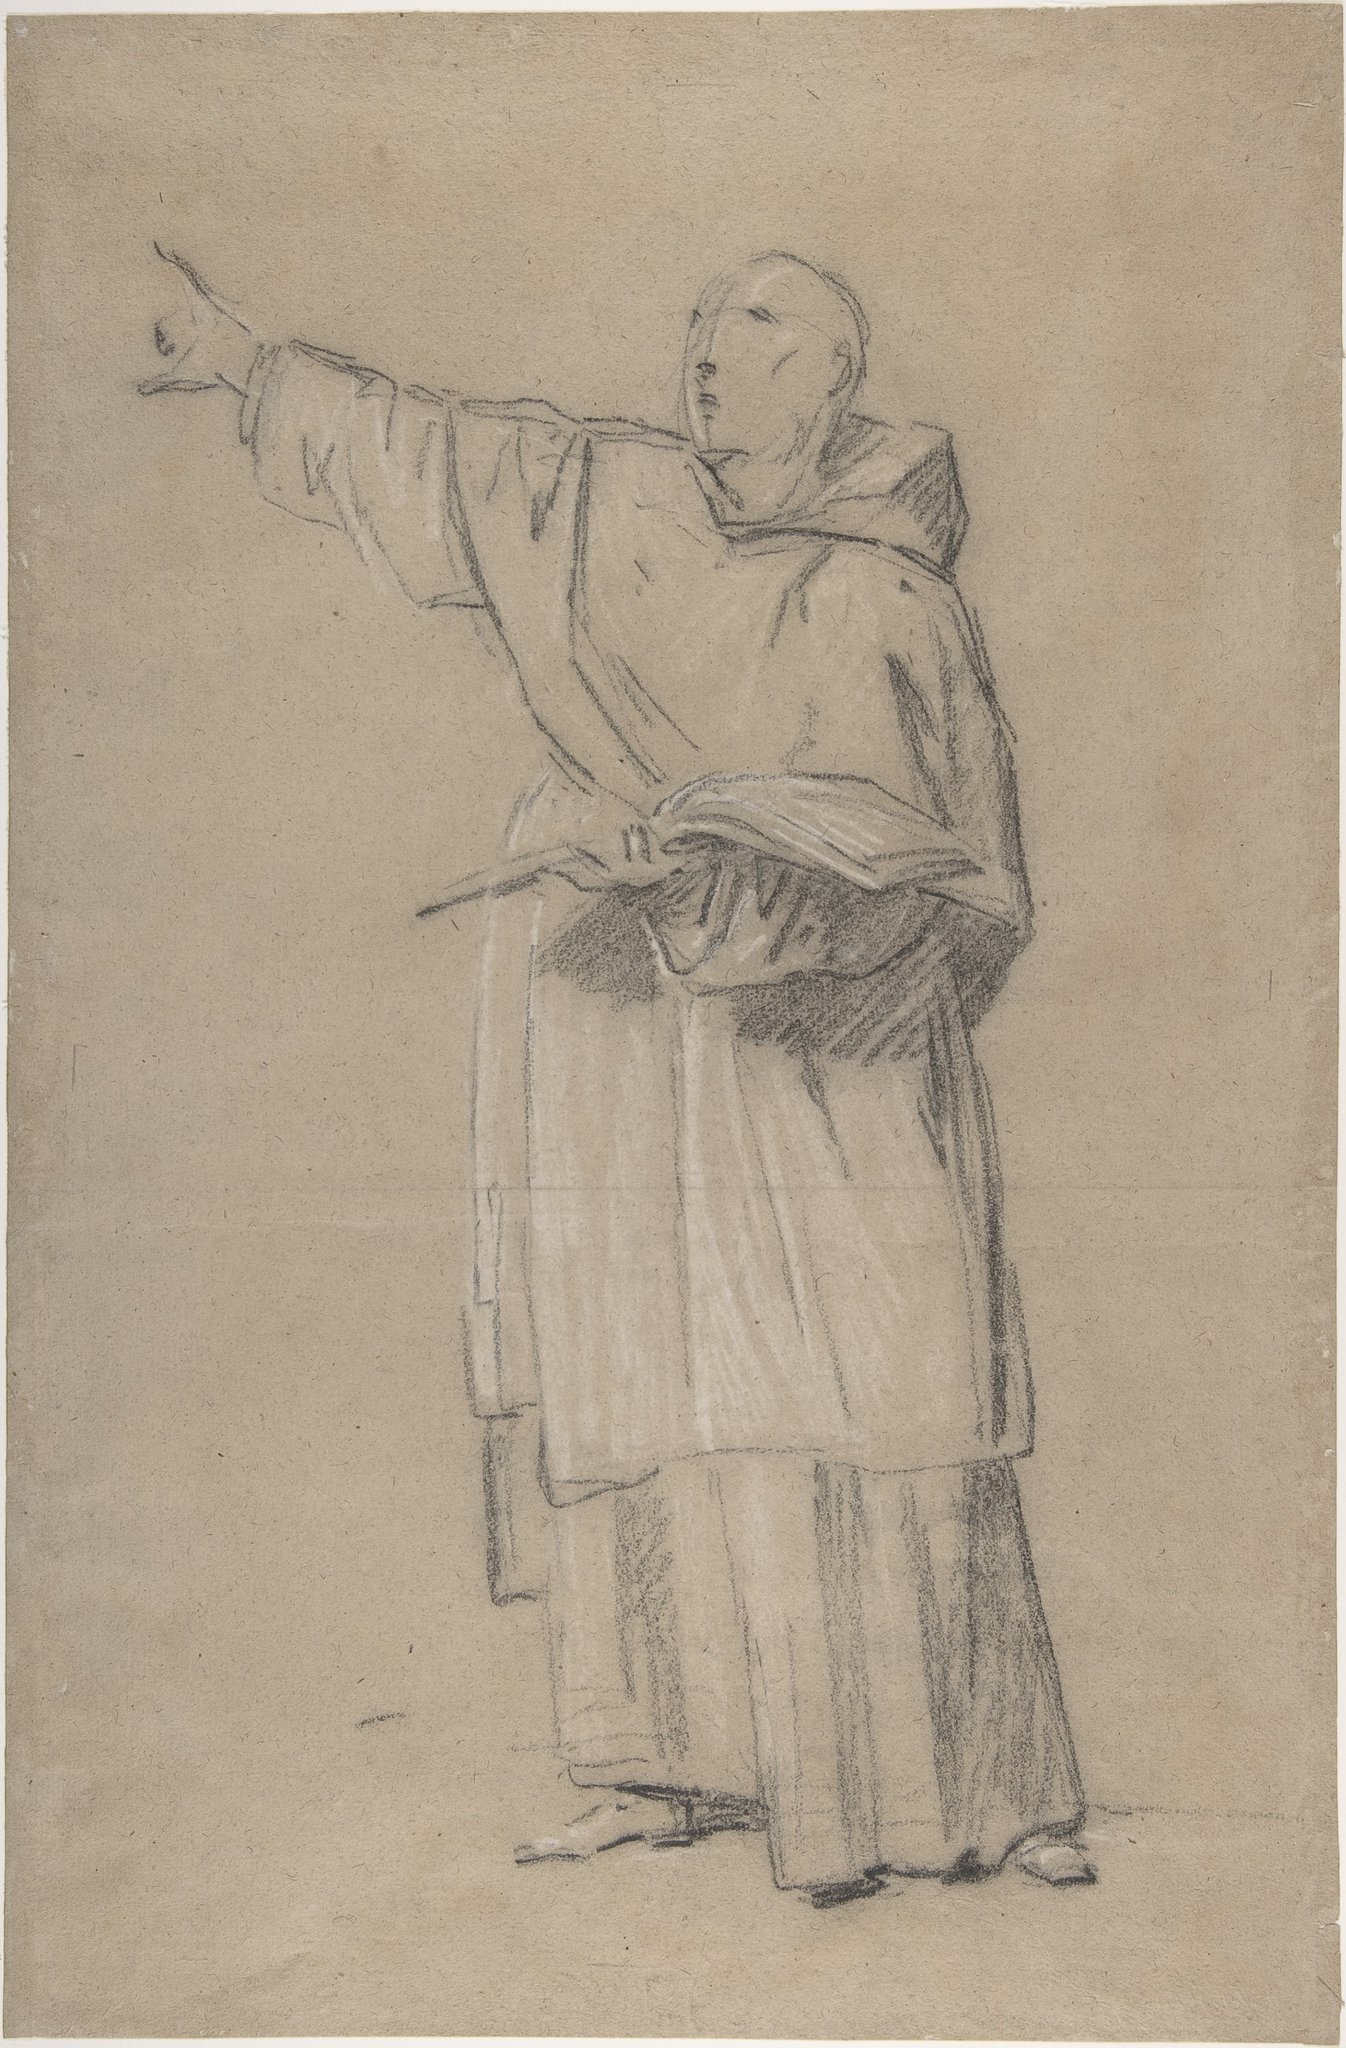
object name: drawing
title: A standing monk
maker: anonymous, french, 18th century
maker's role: artist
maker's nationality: french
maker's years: 1700-1800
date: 1701-1800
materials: chalk, paper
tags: men,monks